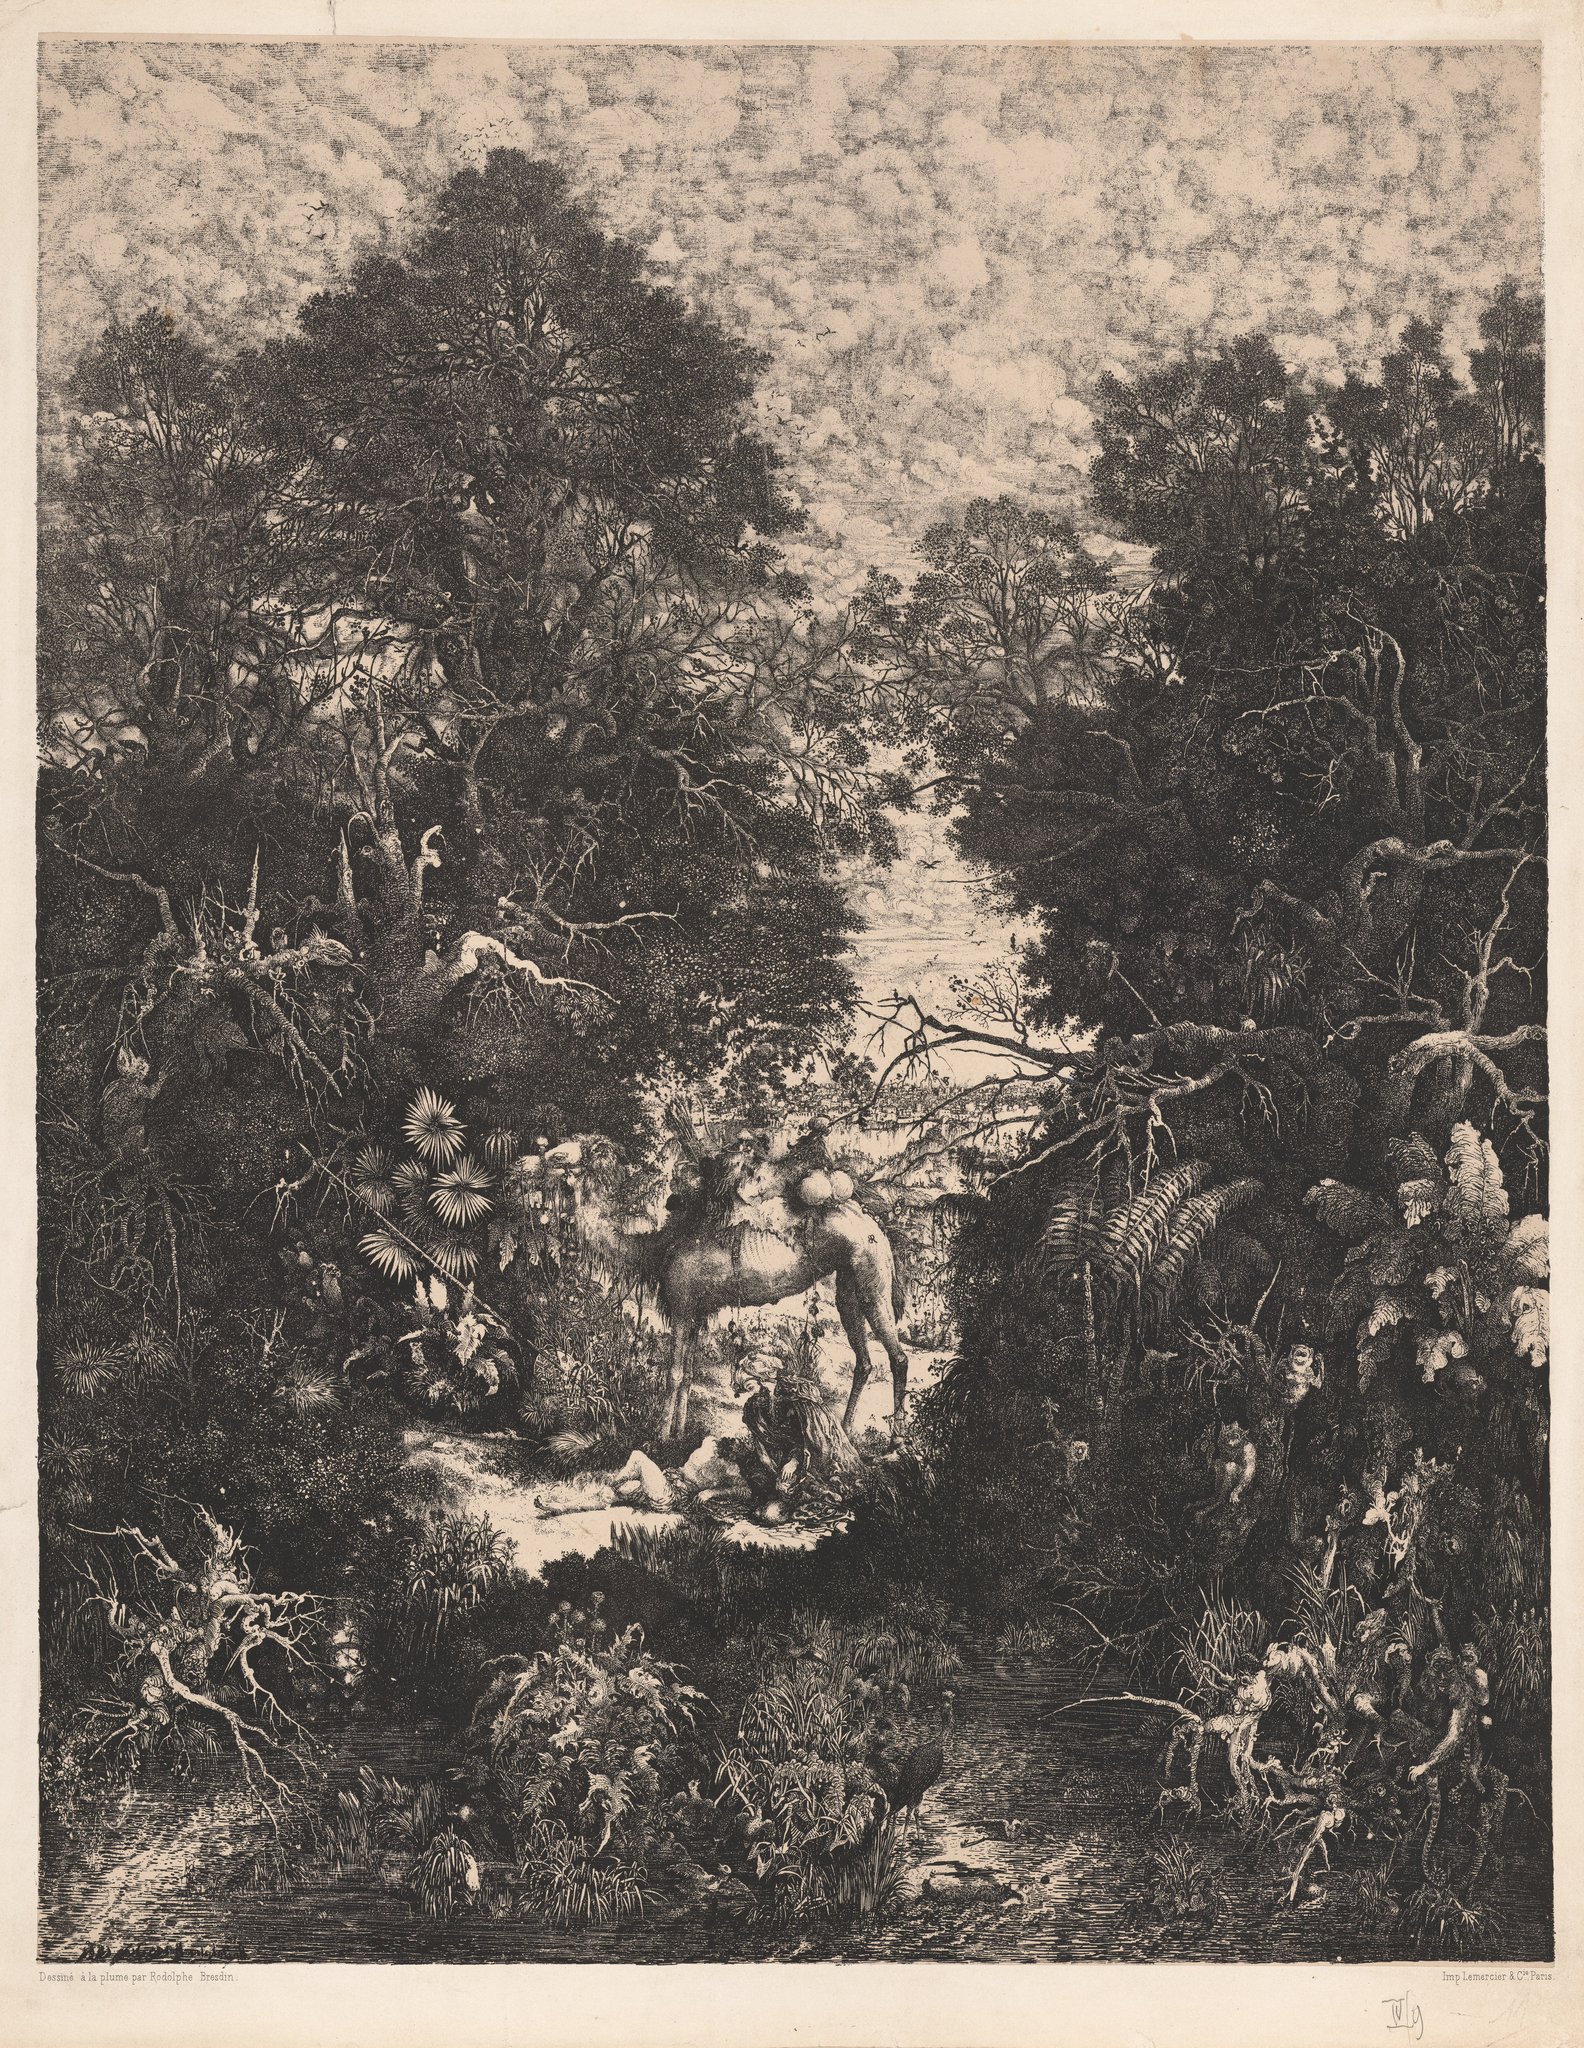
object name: print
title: Le Bon Samaritain (The Good Samaritan)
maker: rodolphe bresdin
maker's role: artist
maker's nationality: french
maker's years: 1822-1885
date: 1861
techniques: lithograph